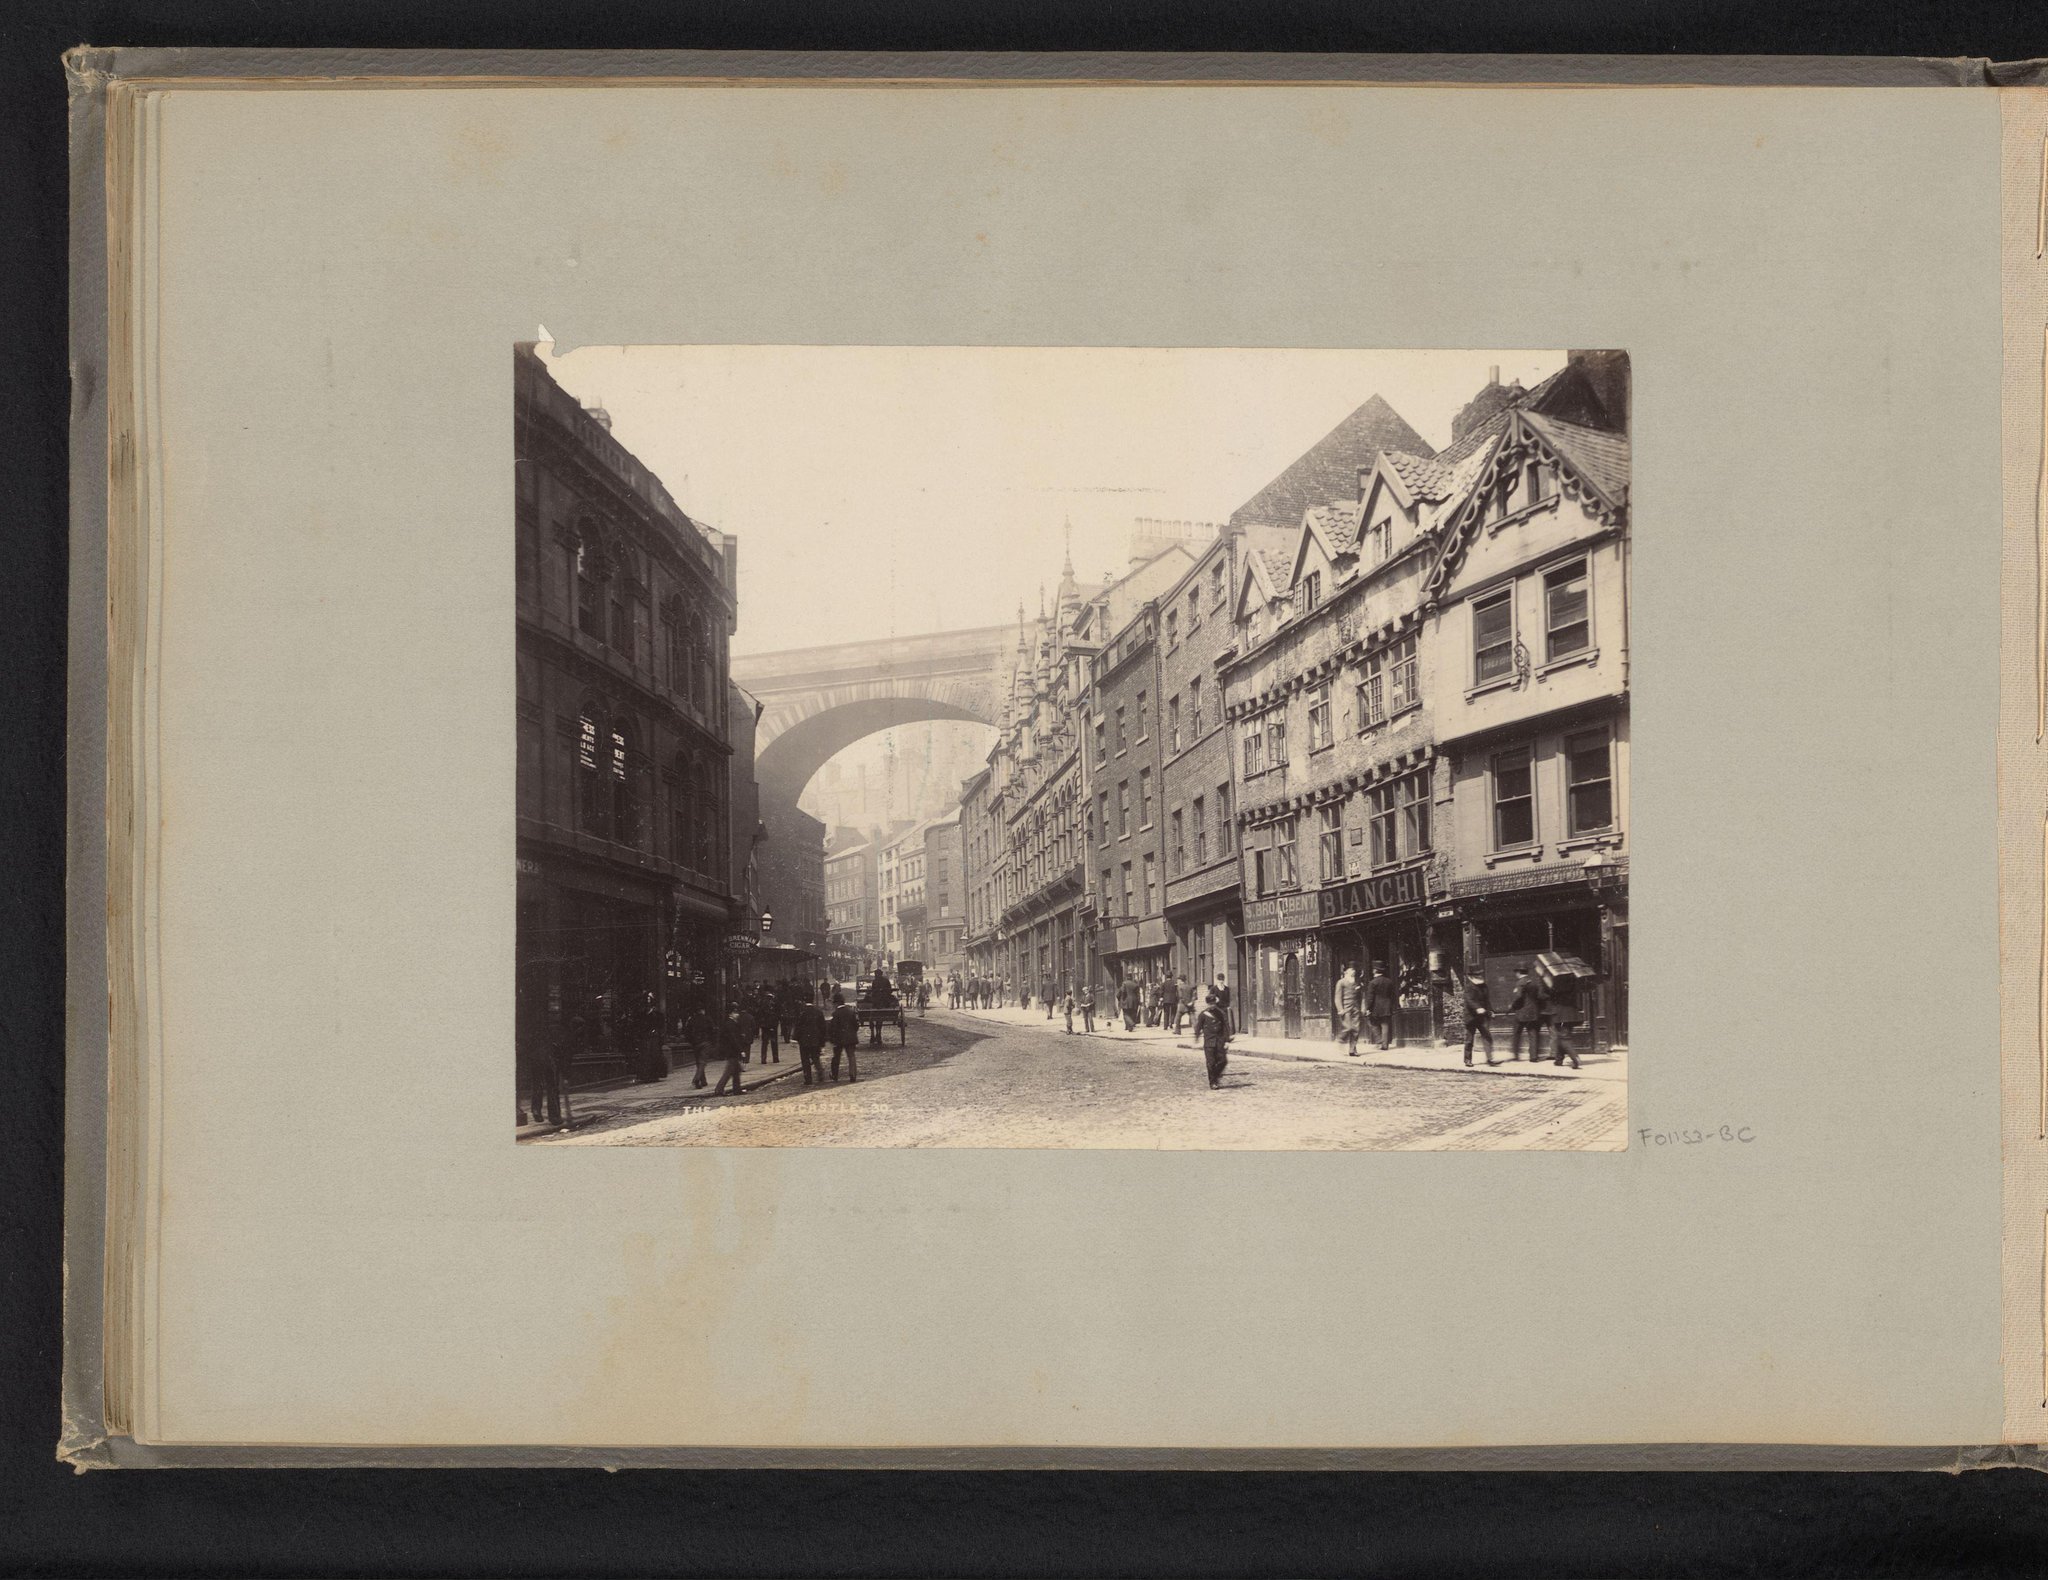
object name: photograph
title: Straatgezicht van Side te Newcastle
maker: Anonymous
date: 1880-1900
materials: photographic support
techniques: albumen print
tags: street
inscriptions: inscription: ‘The Side, Newcastle 30.’